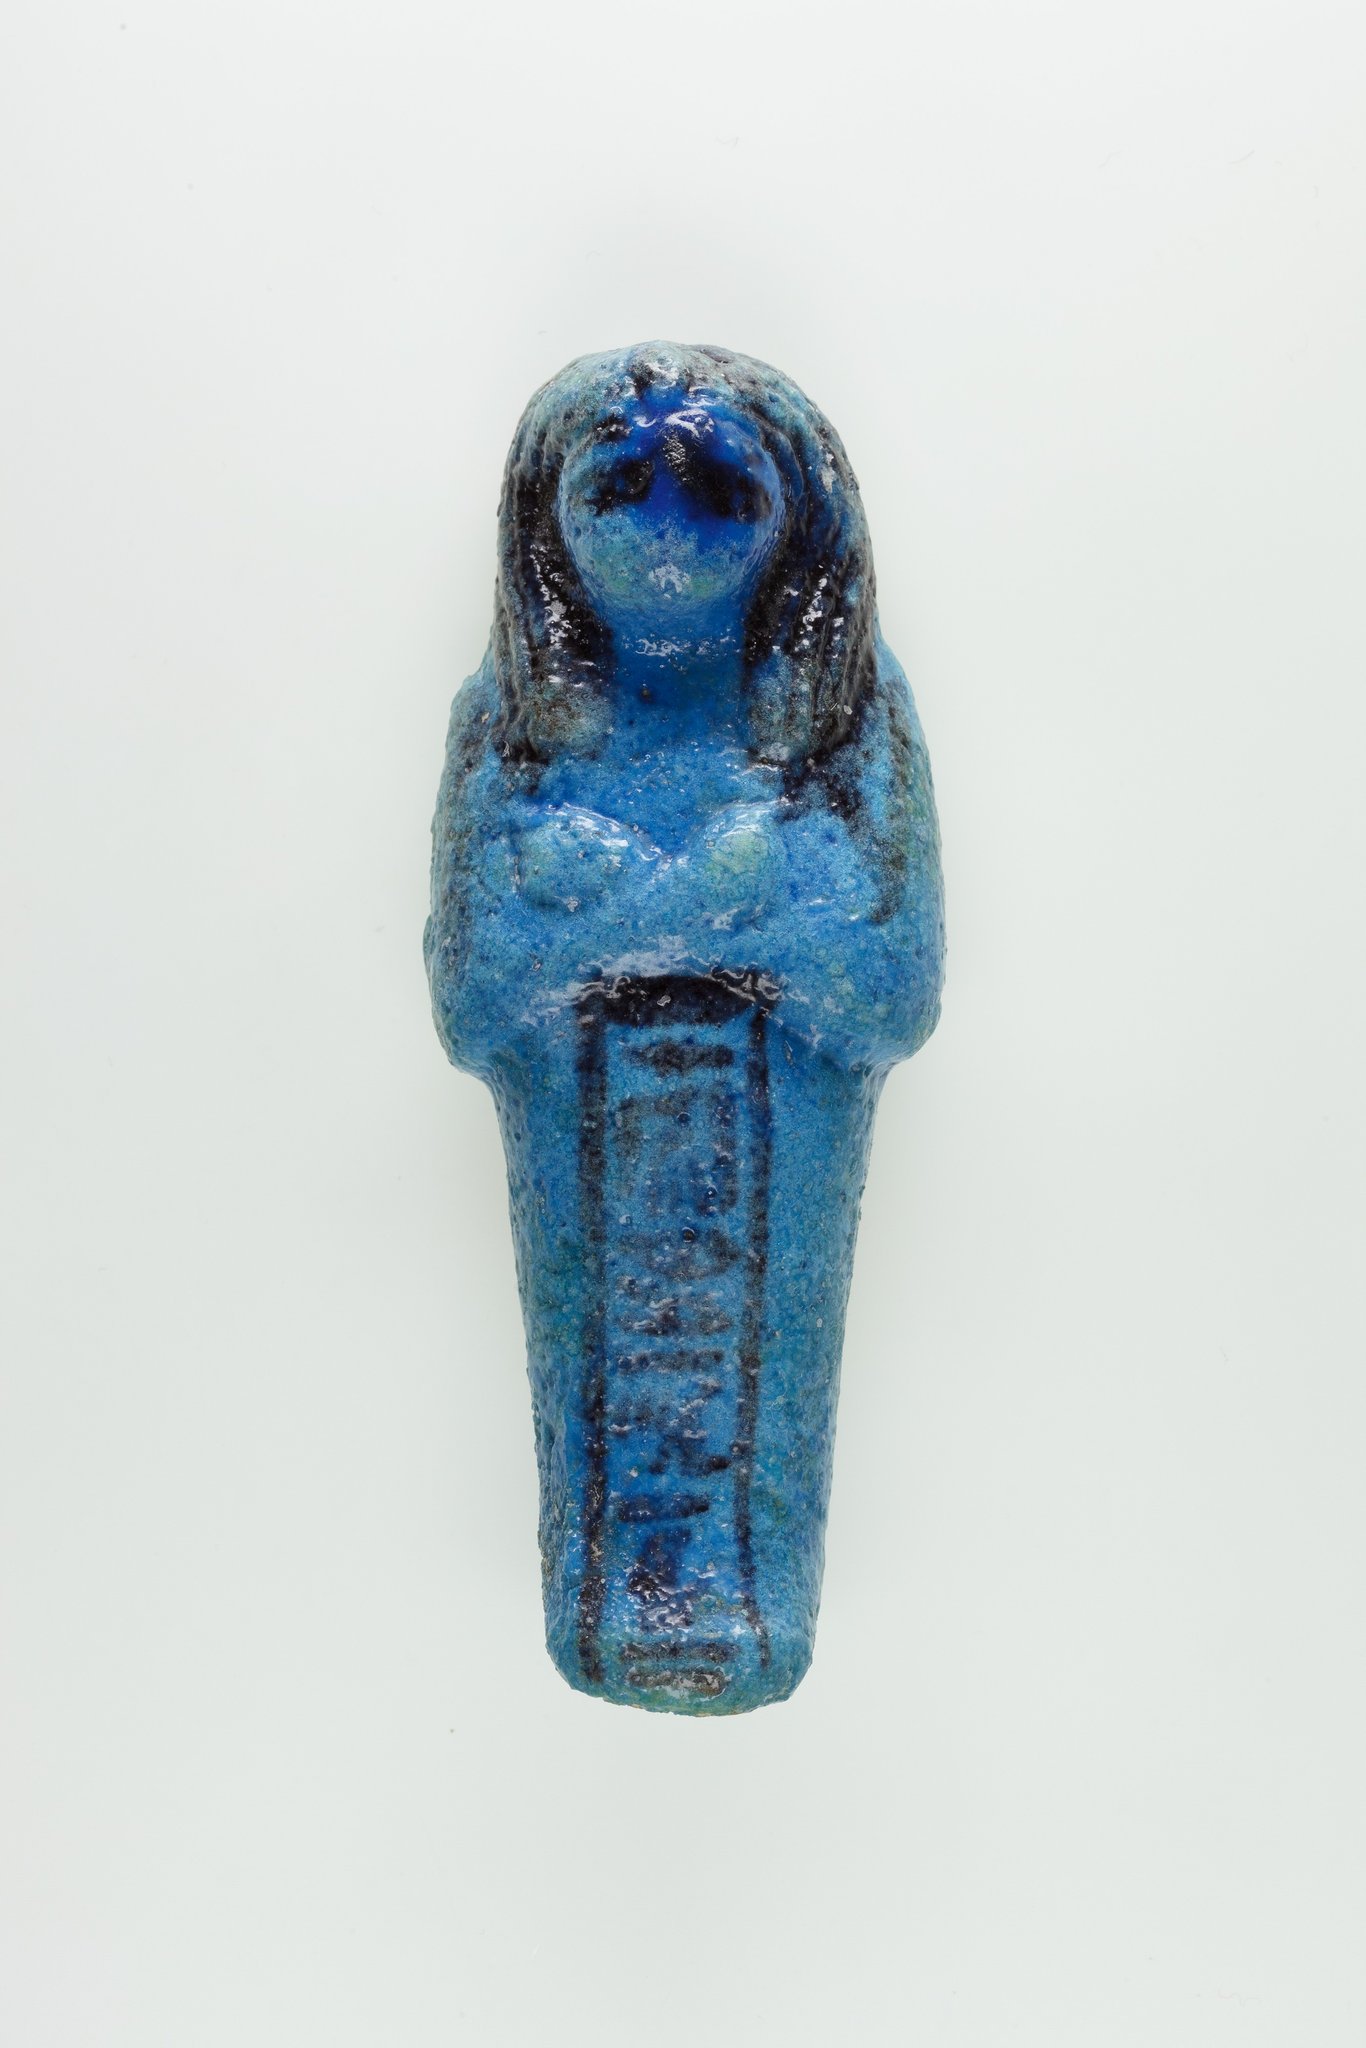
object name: shabti, worker, nauny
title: Worker Shabti of Nauny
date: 1050 BCE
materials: faience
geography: egypt